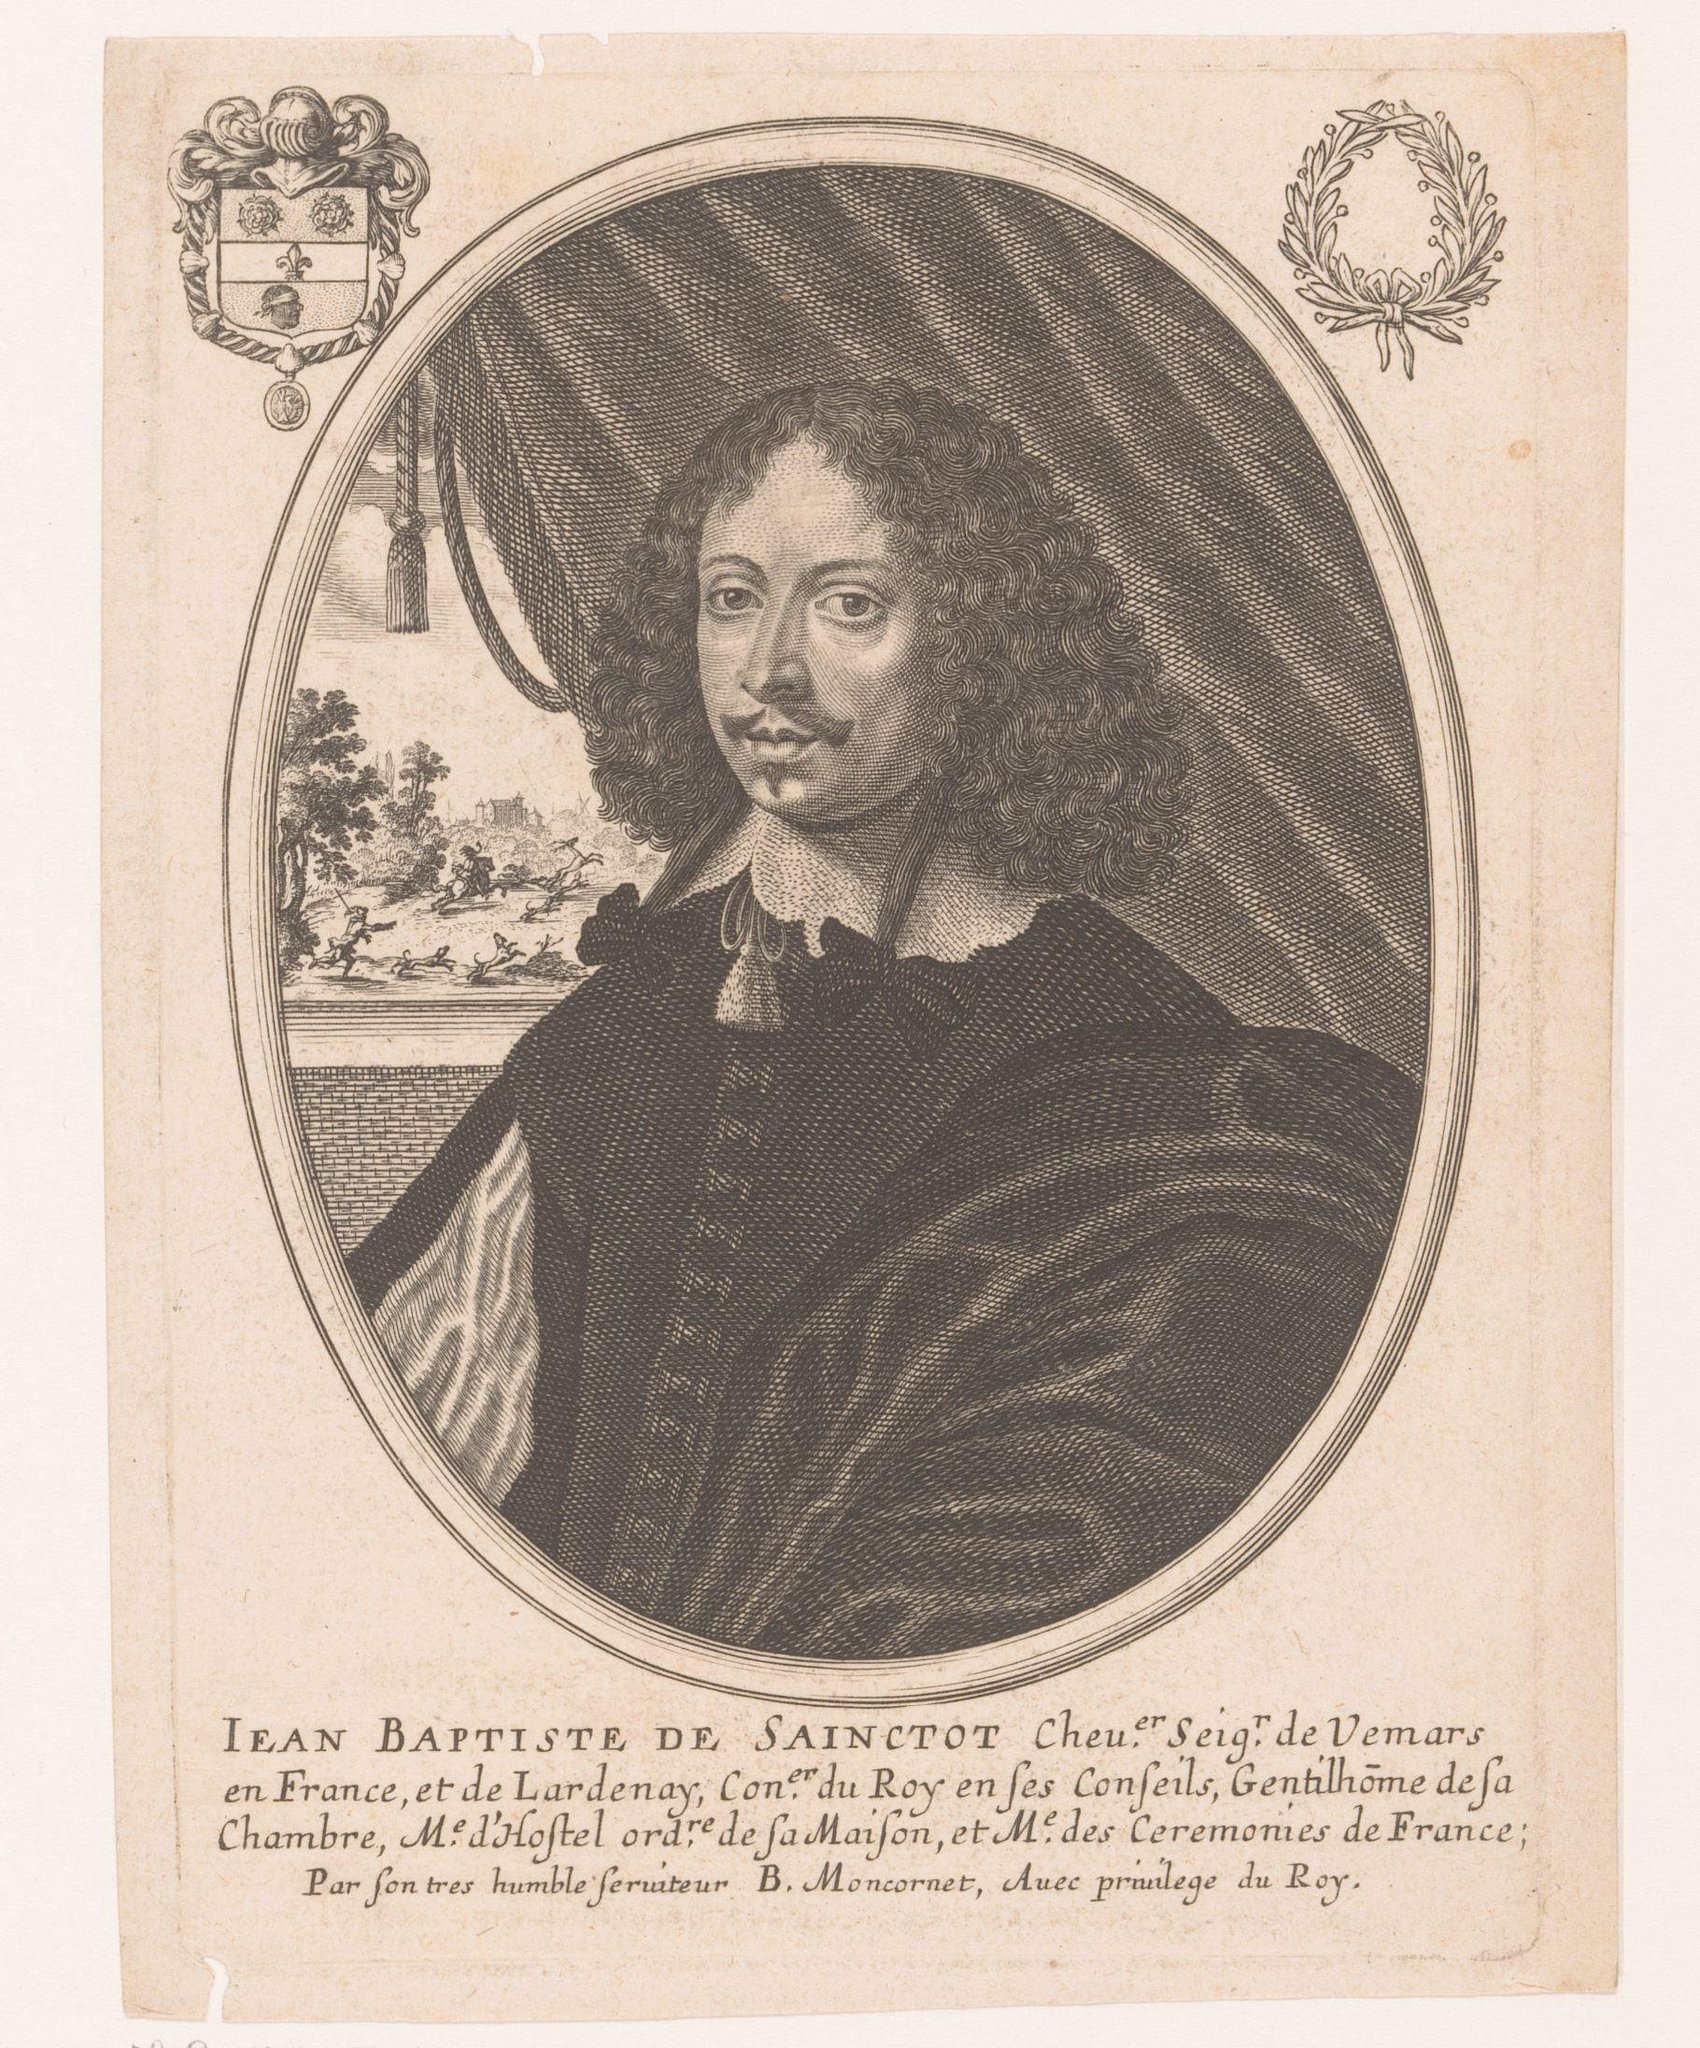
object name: print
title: Portret van Jean Baptiste de Sainctot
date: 1610-1668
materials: paper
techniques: engraving, etching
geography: paris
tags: historical persons, armorial bearing, heraldry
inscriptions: collector's mark: Lugt 2228